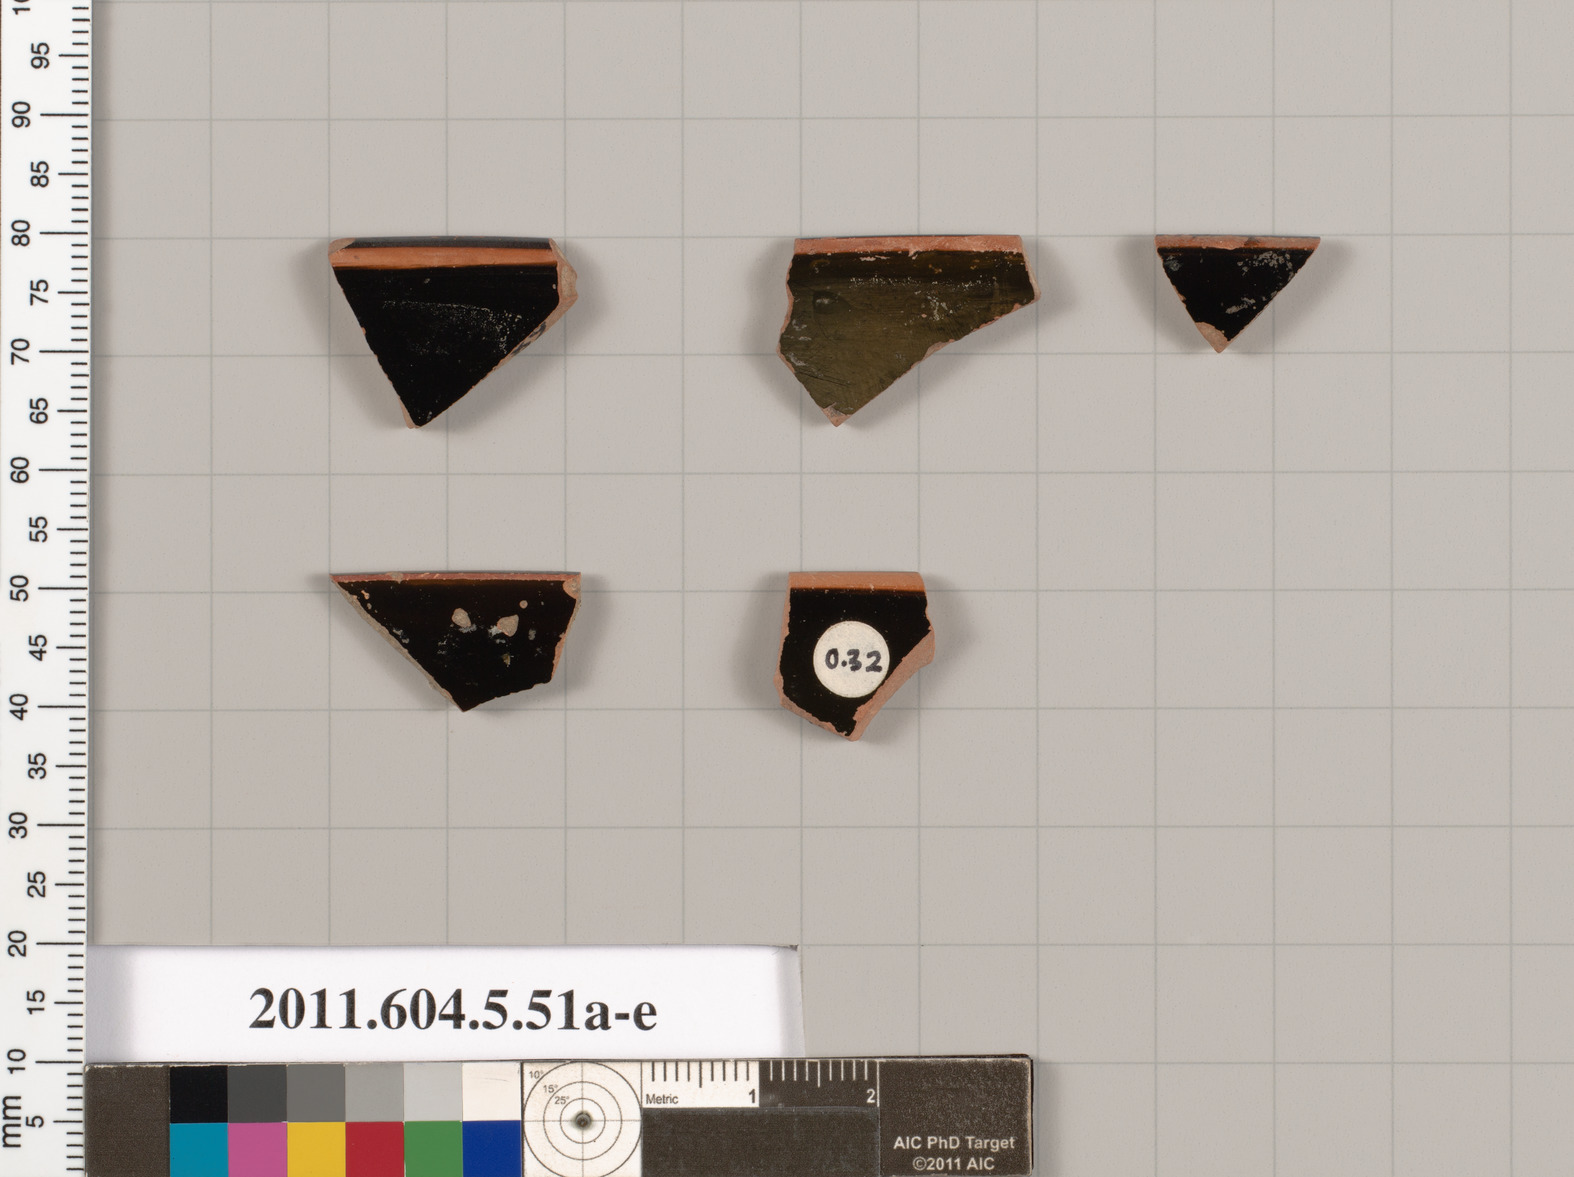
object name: kylix fragment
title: Terracotta rim fragments of kylikes (drinking cups)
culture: greek, attic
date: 500-401 BCE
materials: terracotta